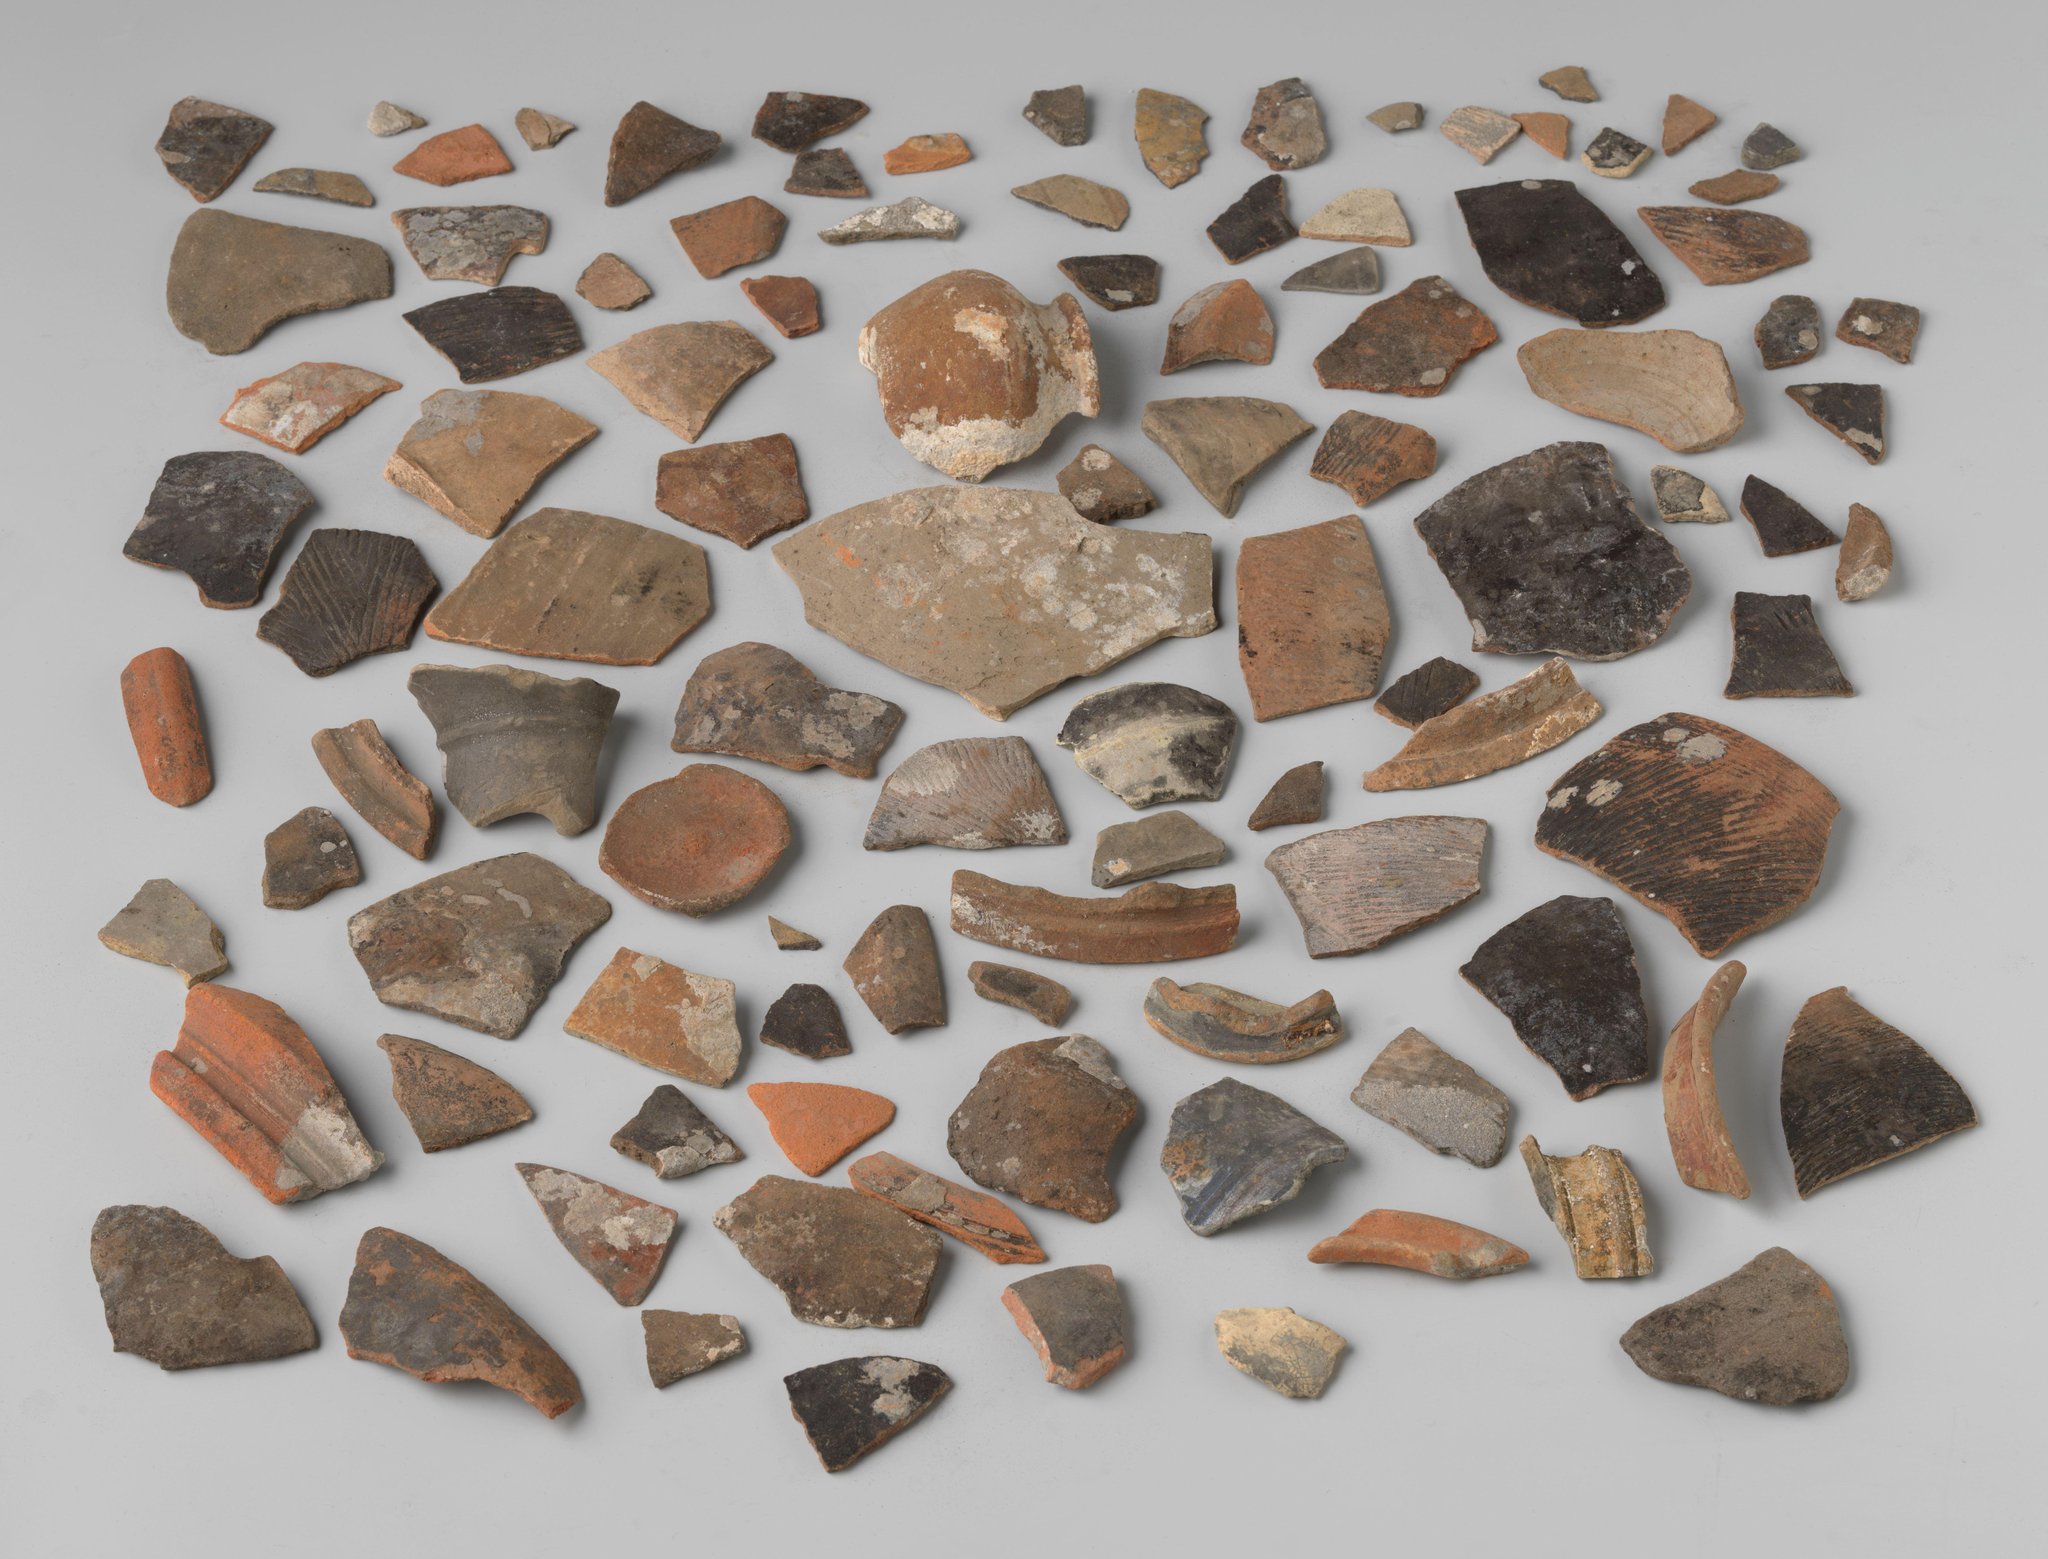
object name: sherd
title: Scherven aardewerk uit V.O.C.-schip de 'Witte Leeuw'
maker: Anonymous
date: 1613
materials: earthenware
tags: verenigde oostindische compagnie, sint-helena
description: Scherven van roodbakkend, grijsbakkend en geelbakkend aardewerk uit V.O.C.-schip de 'Witte Leeuw'.